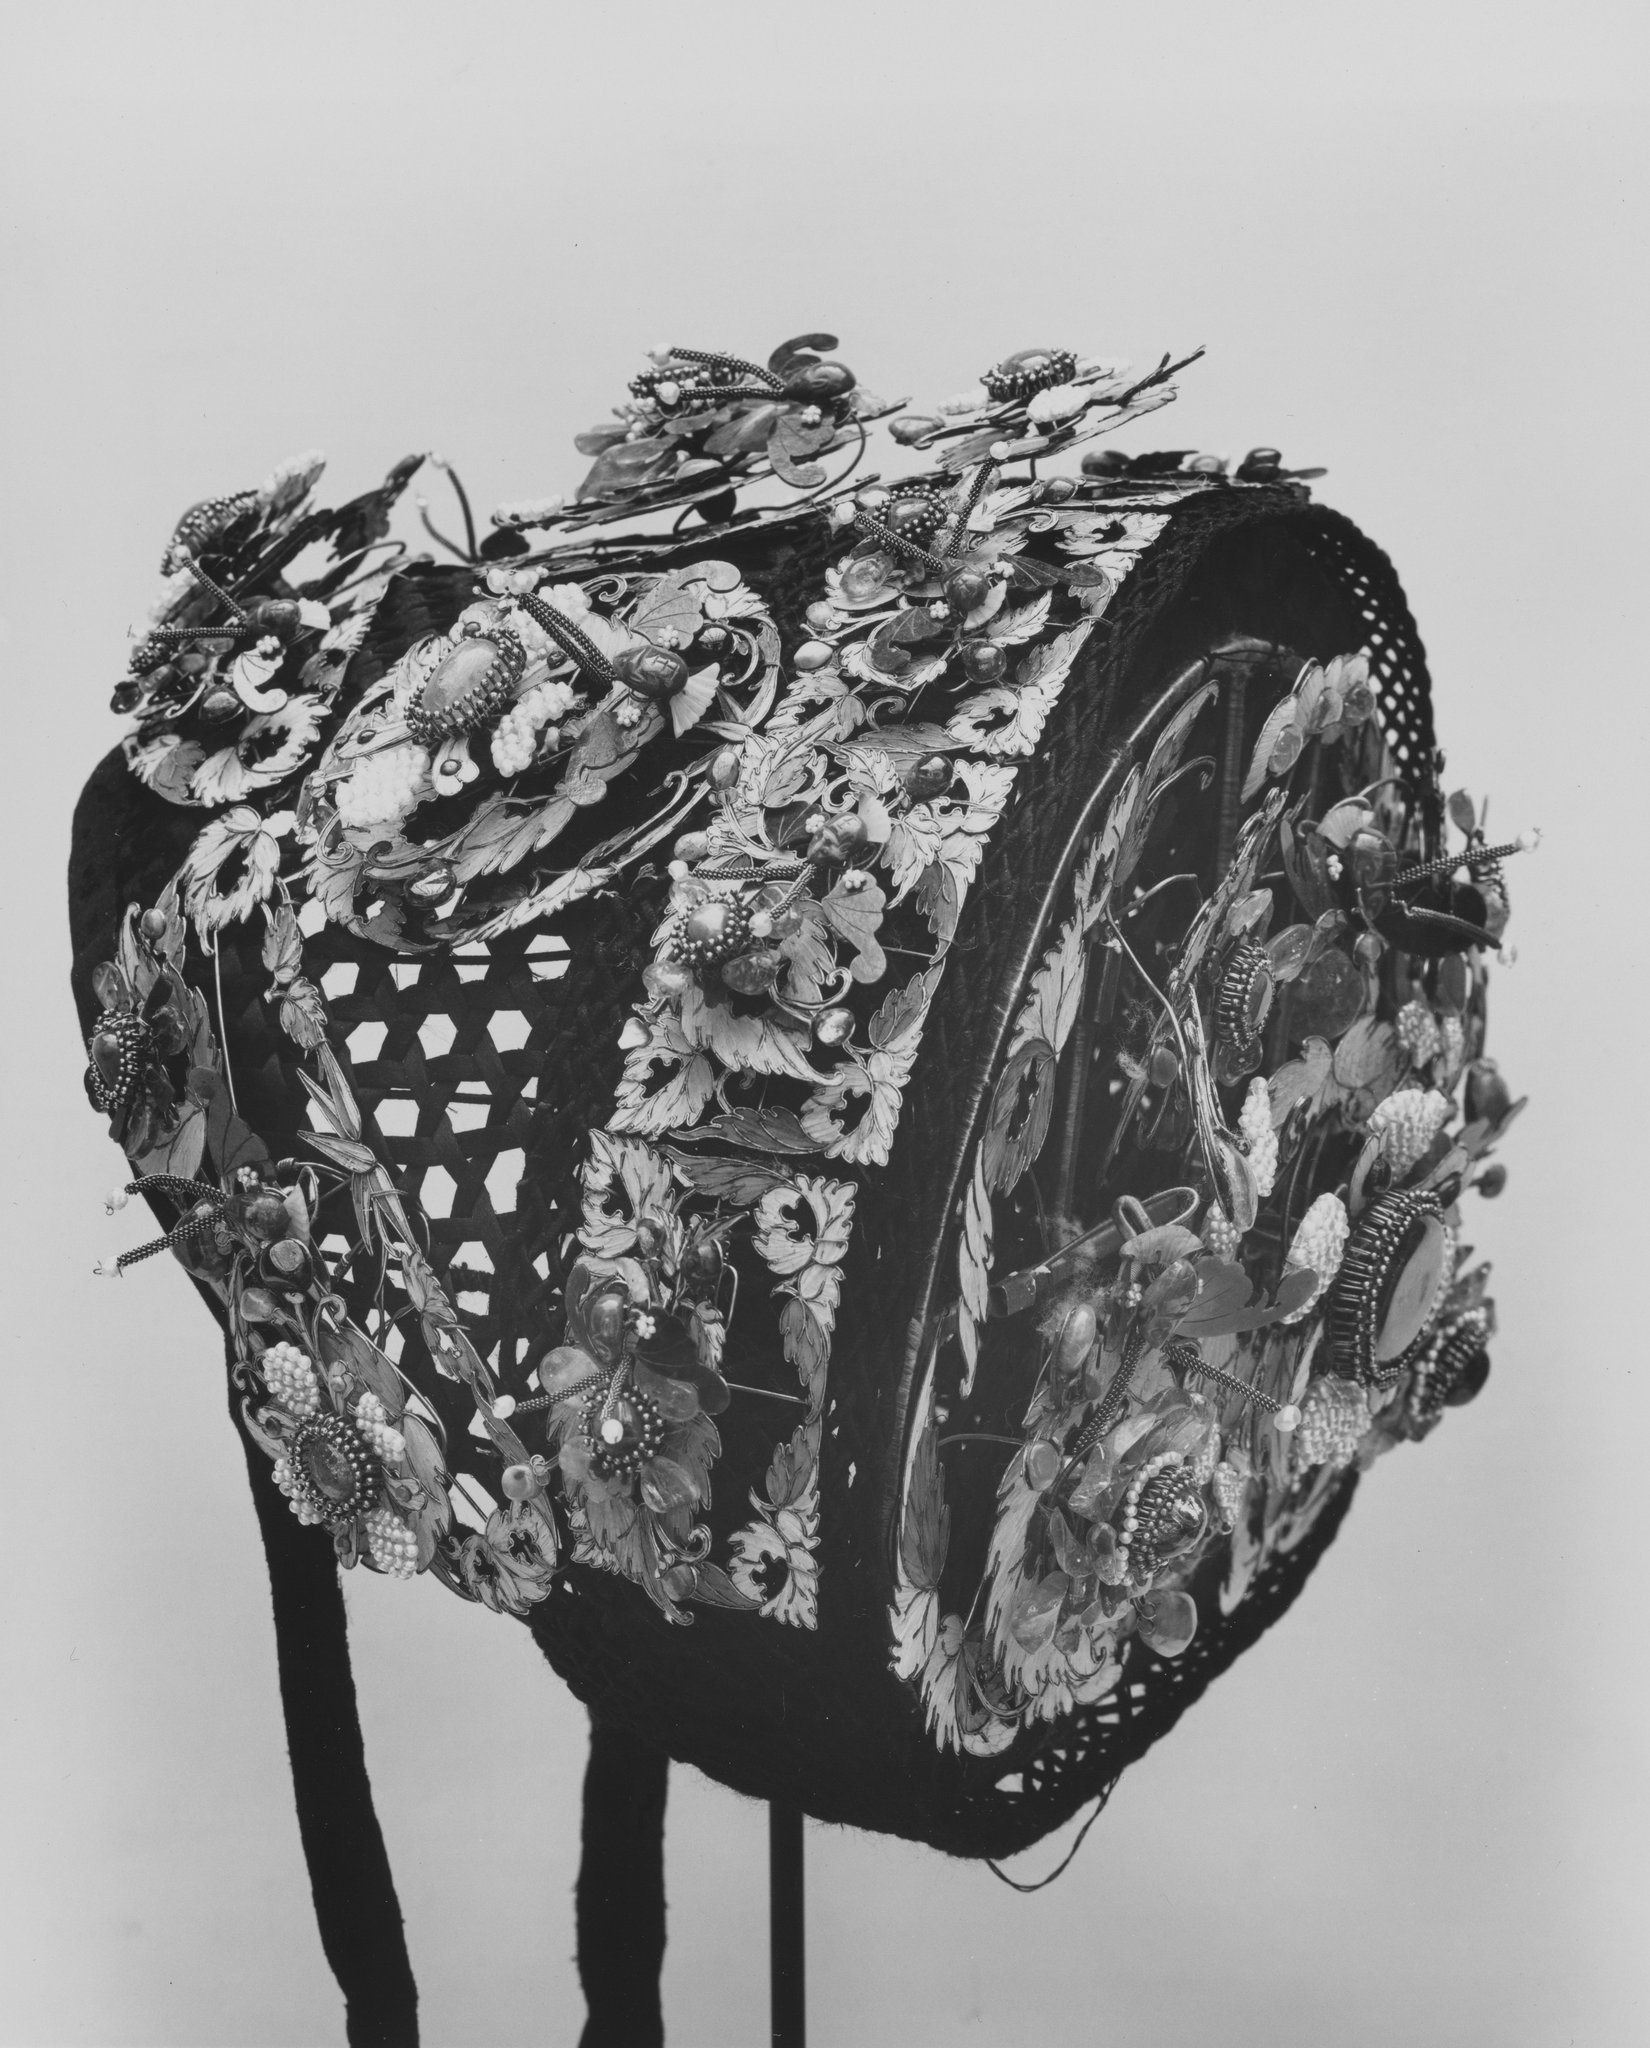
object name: court headdress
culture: chinese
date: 1701-1900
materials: gilt, gold, metal, stone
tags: flowers